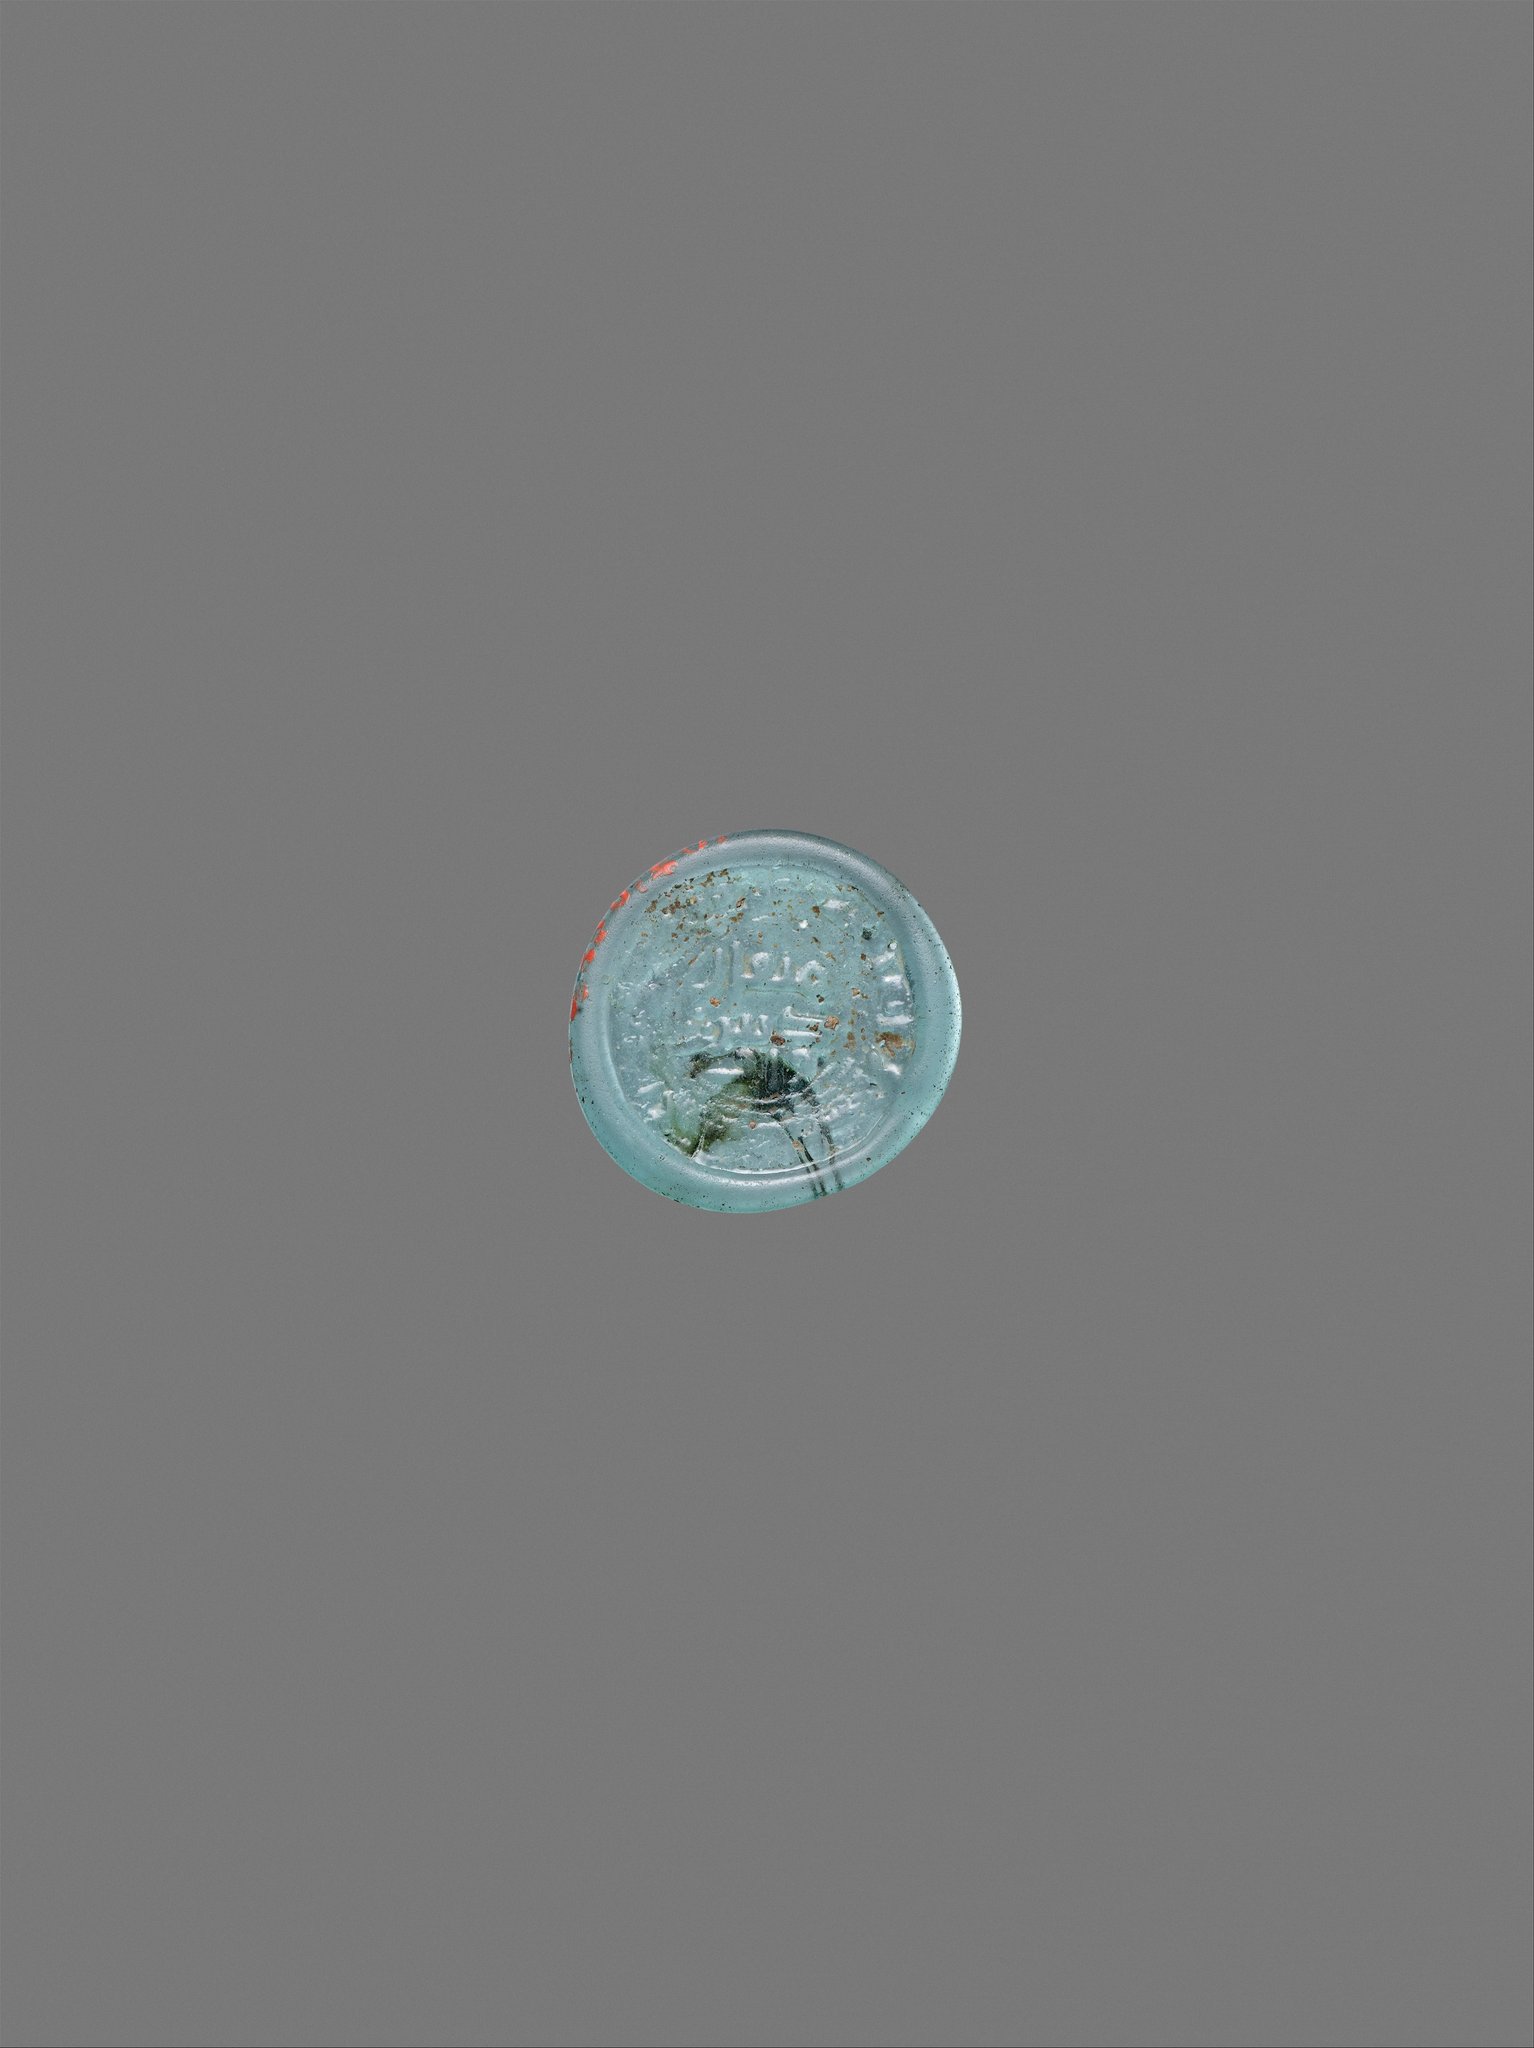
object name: coin weight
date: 808-810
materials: glass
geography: egypt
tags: arabic